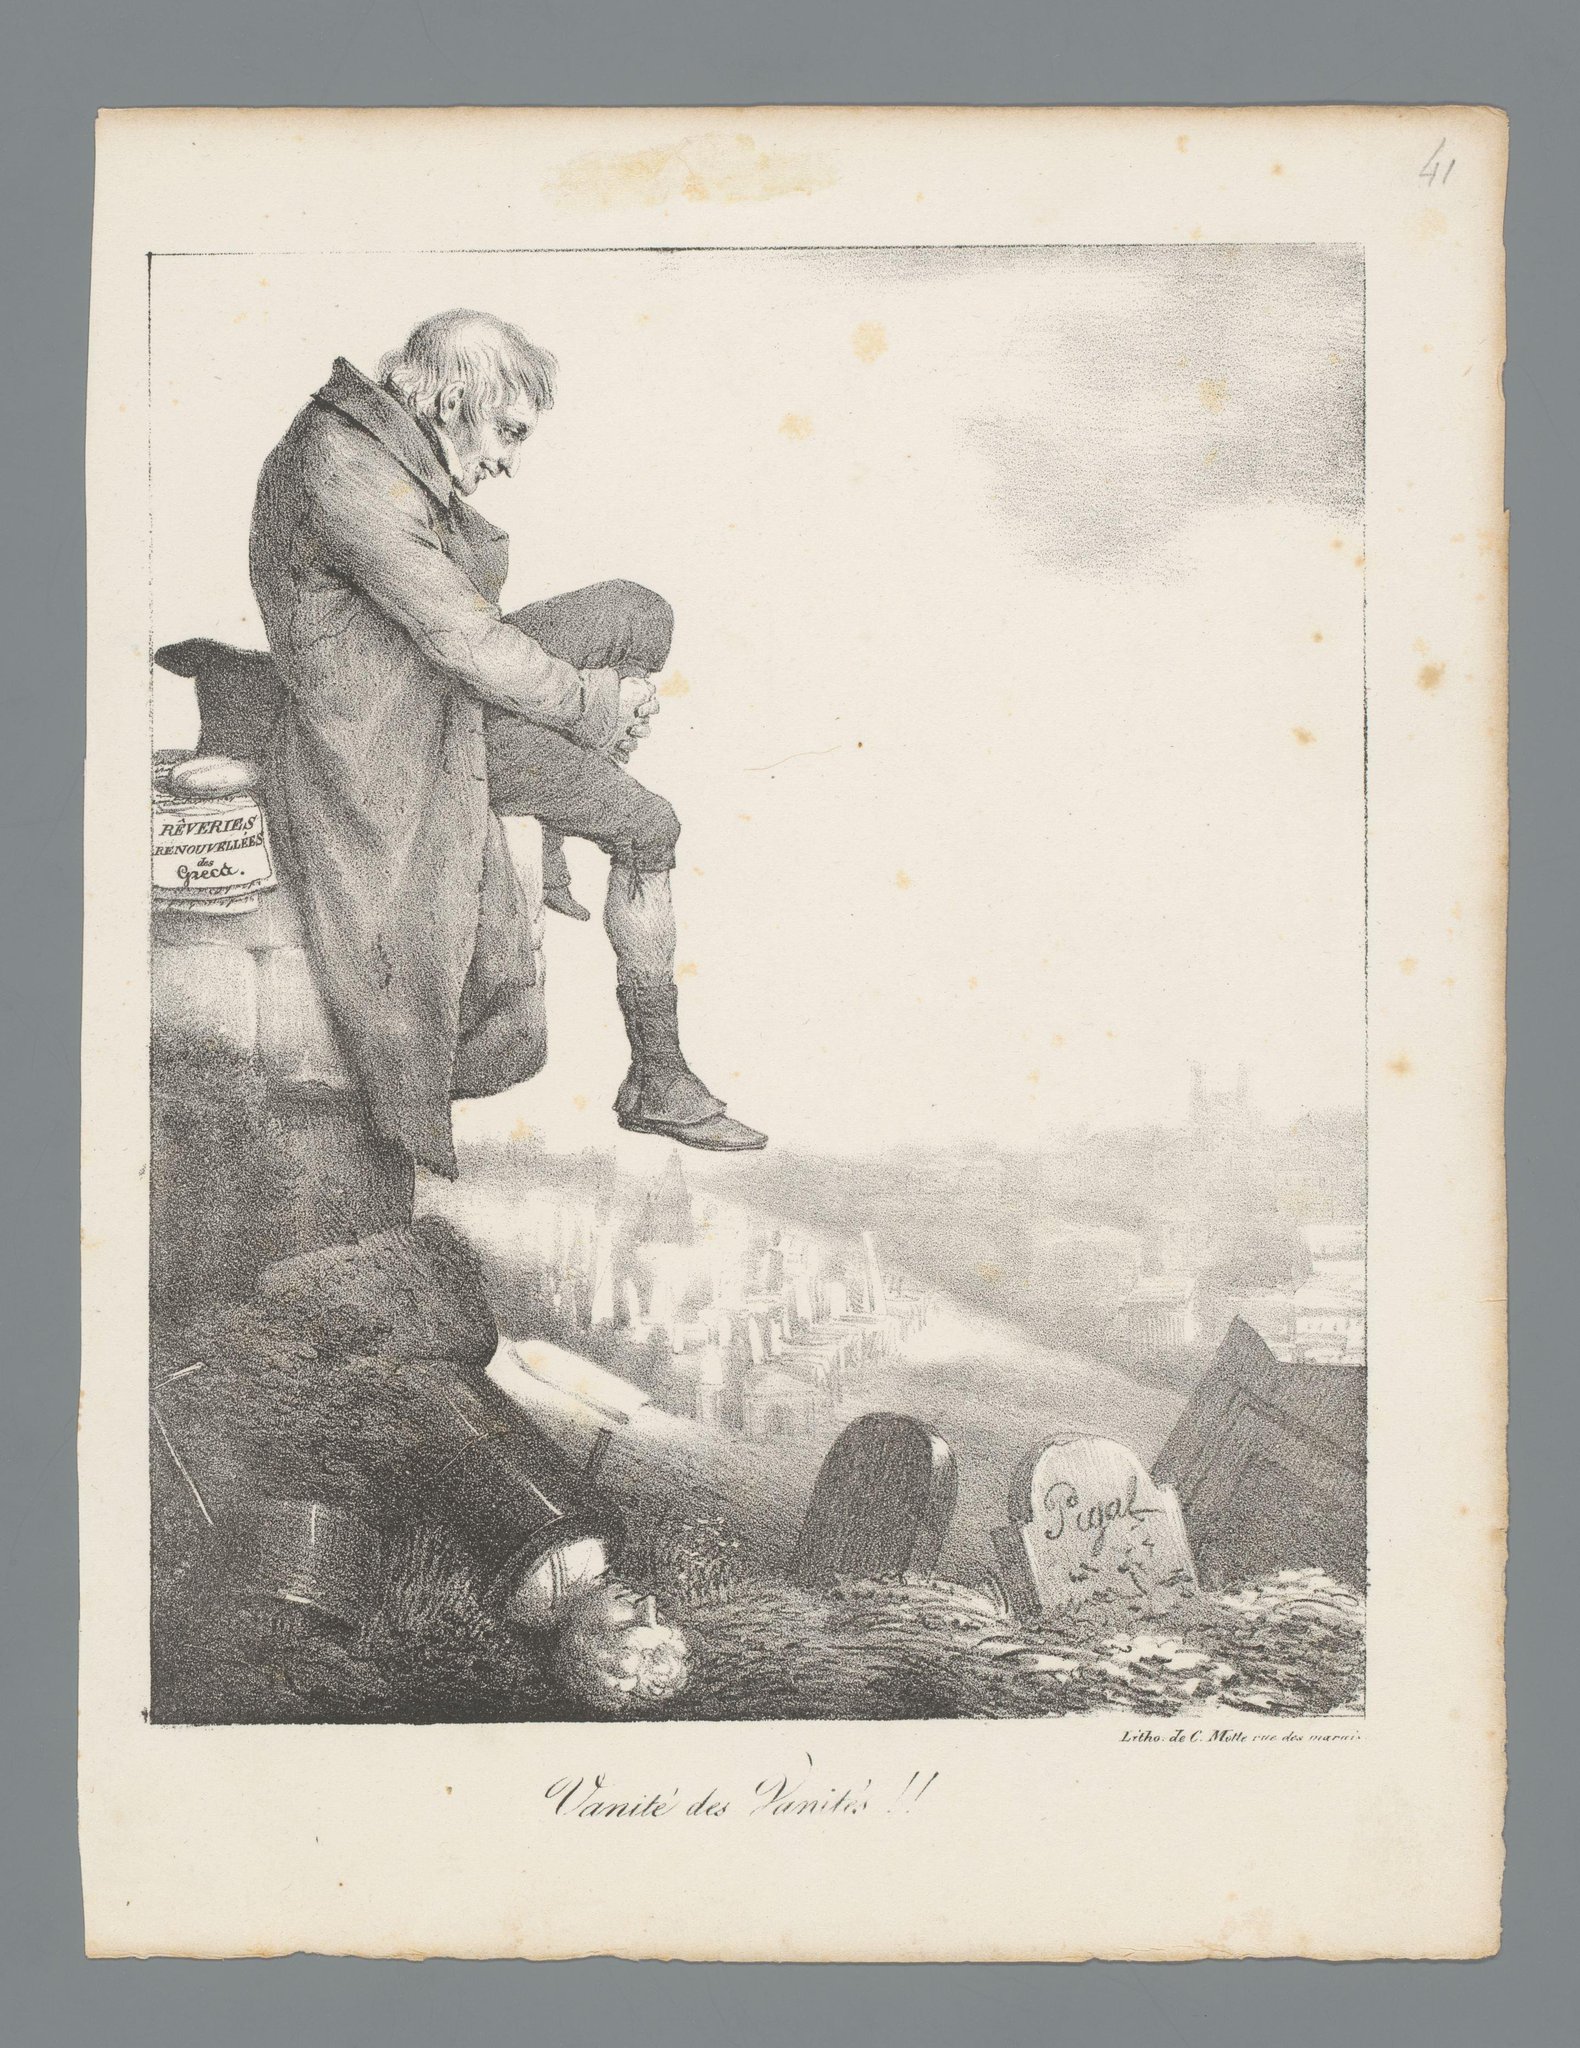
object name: print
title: Vanité des vanités!!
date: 1823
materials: paper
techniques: lithograph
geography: paris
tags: adult man, churchyard, cemetery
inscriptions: collector's mark: Lugt 2228